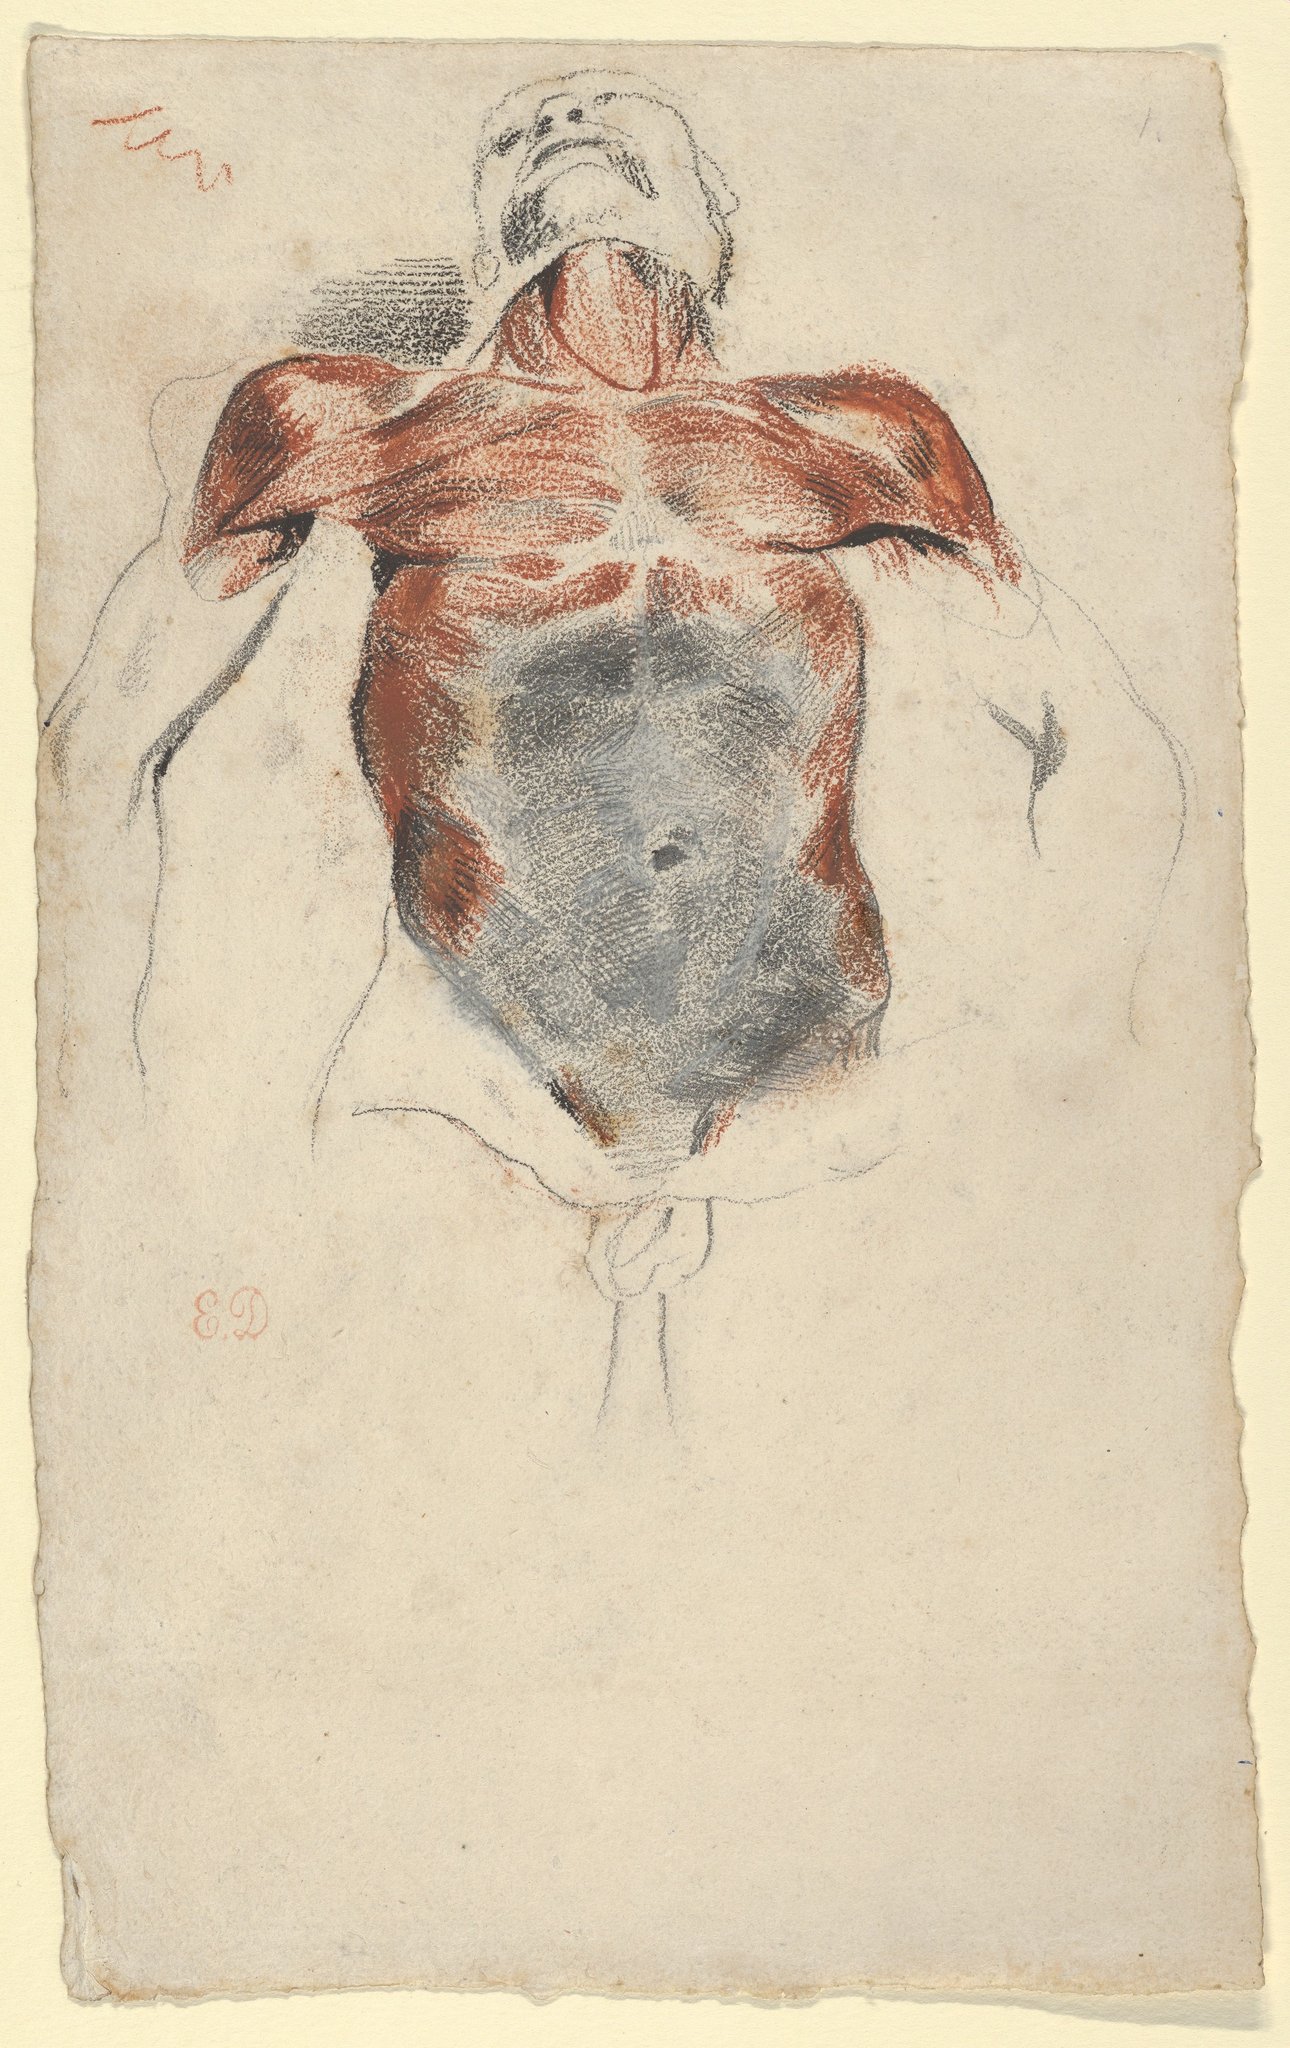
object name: drawing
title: Ecorché: Torso of a Male Cadaver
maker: eugène delacroix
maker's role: artist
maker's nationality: french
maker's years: 1798-1863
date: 1828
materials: chalk, graphite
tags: corpses,male nudes